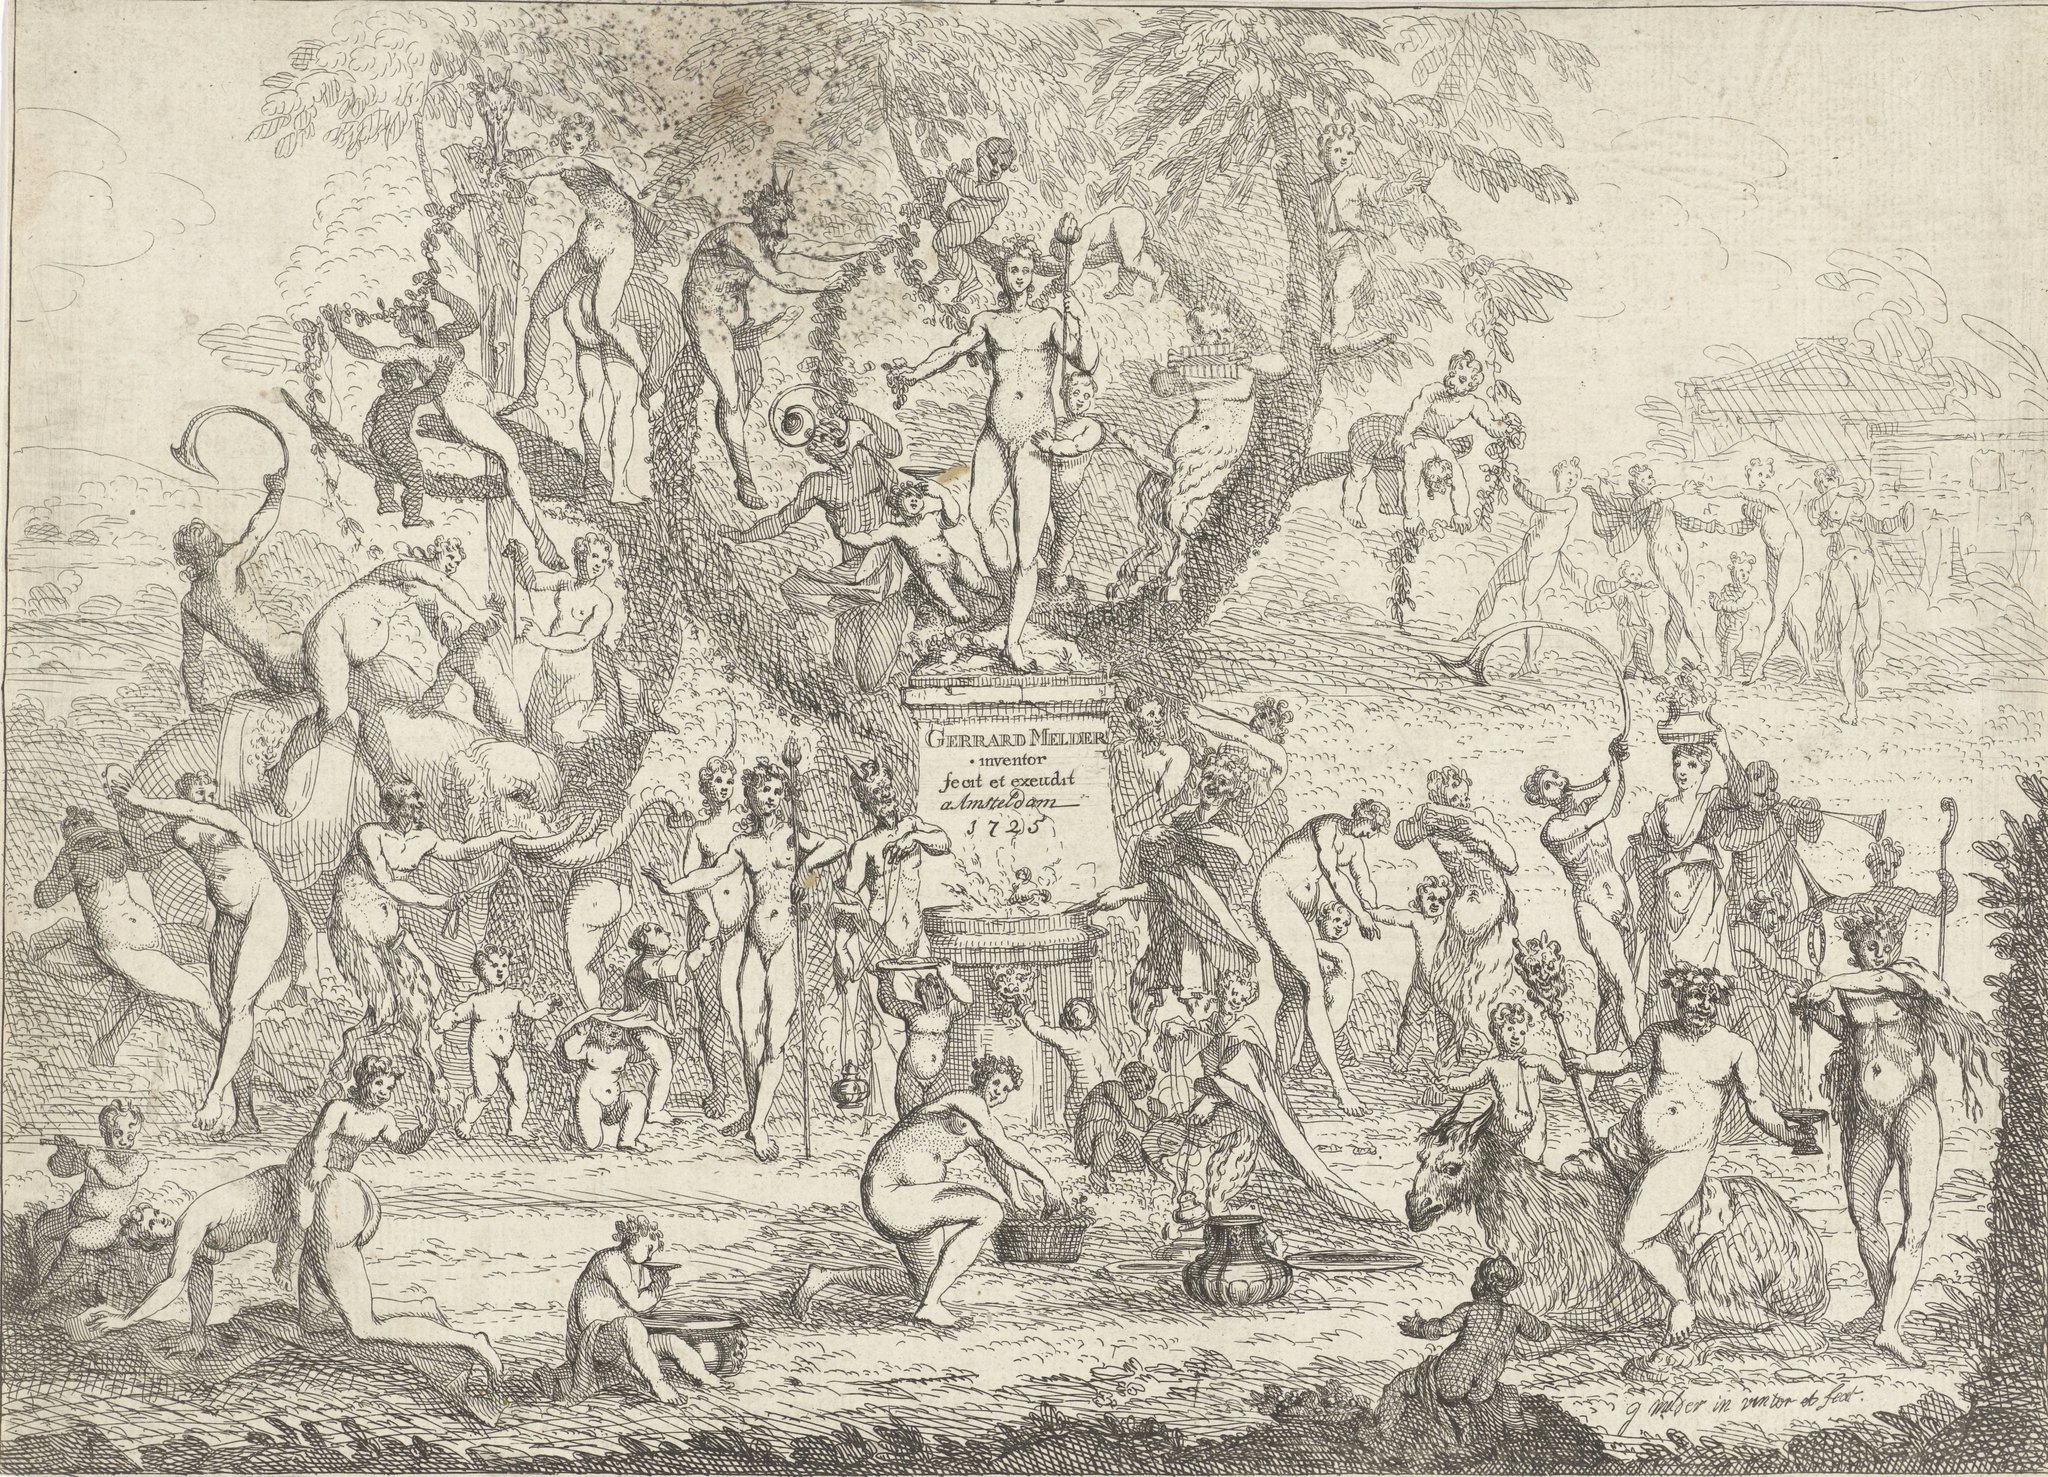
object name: titelprent, frontispice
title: Het leven der Bacchanten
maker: gerard melder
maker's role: painter, print maker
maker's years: 1693-1754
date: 1725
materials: paper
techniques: etching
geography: amsterdam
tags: bacchanal: bacchus with his wine-flushed train (thiasos), trunked animals: elephant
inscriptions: collector's mark: Lugt 2228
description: In het midden staat Bacchus op een voetstuk, waarvoor een altaar is geplaatst. Onder de Bacchanten en Saters bevindt zich rechts Silenus, op zijn ezel gezeten; links een groep vrouwen met een olifant.